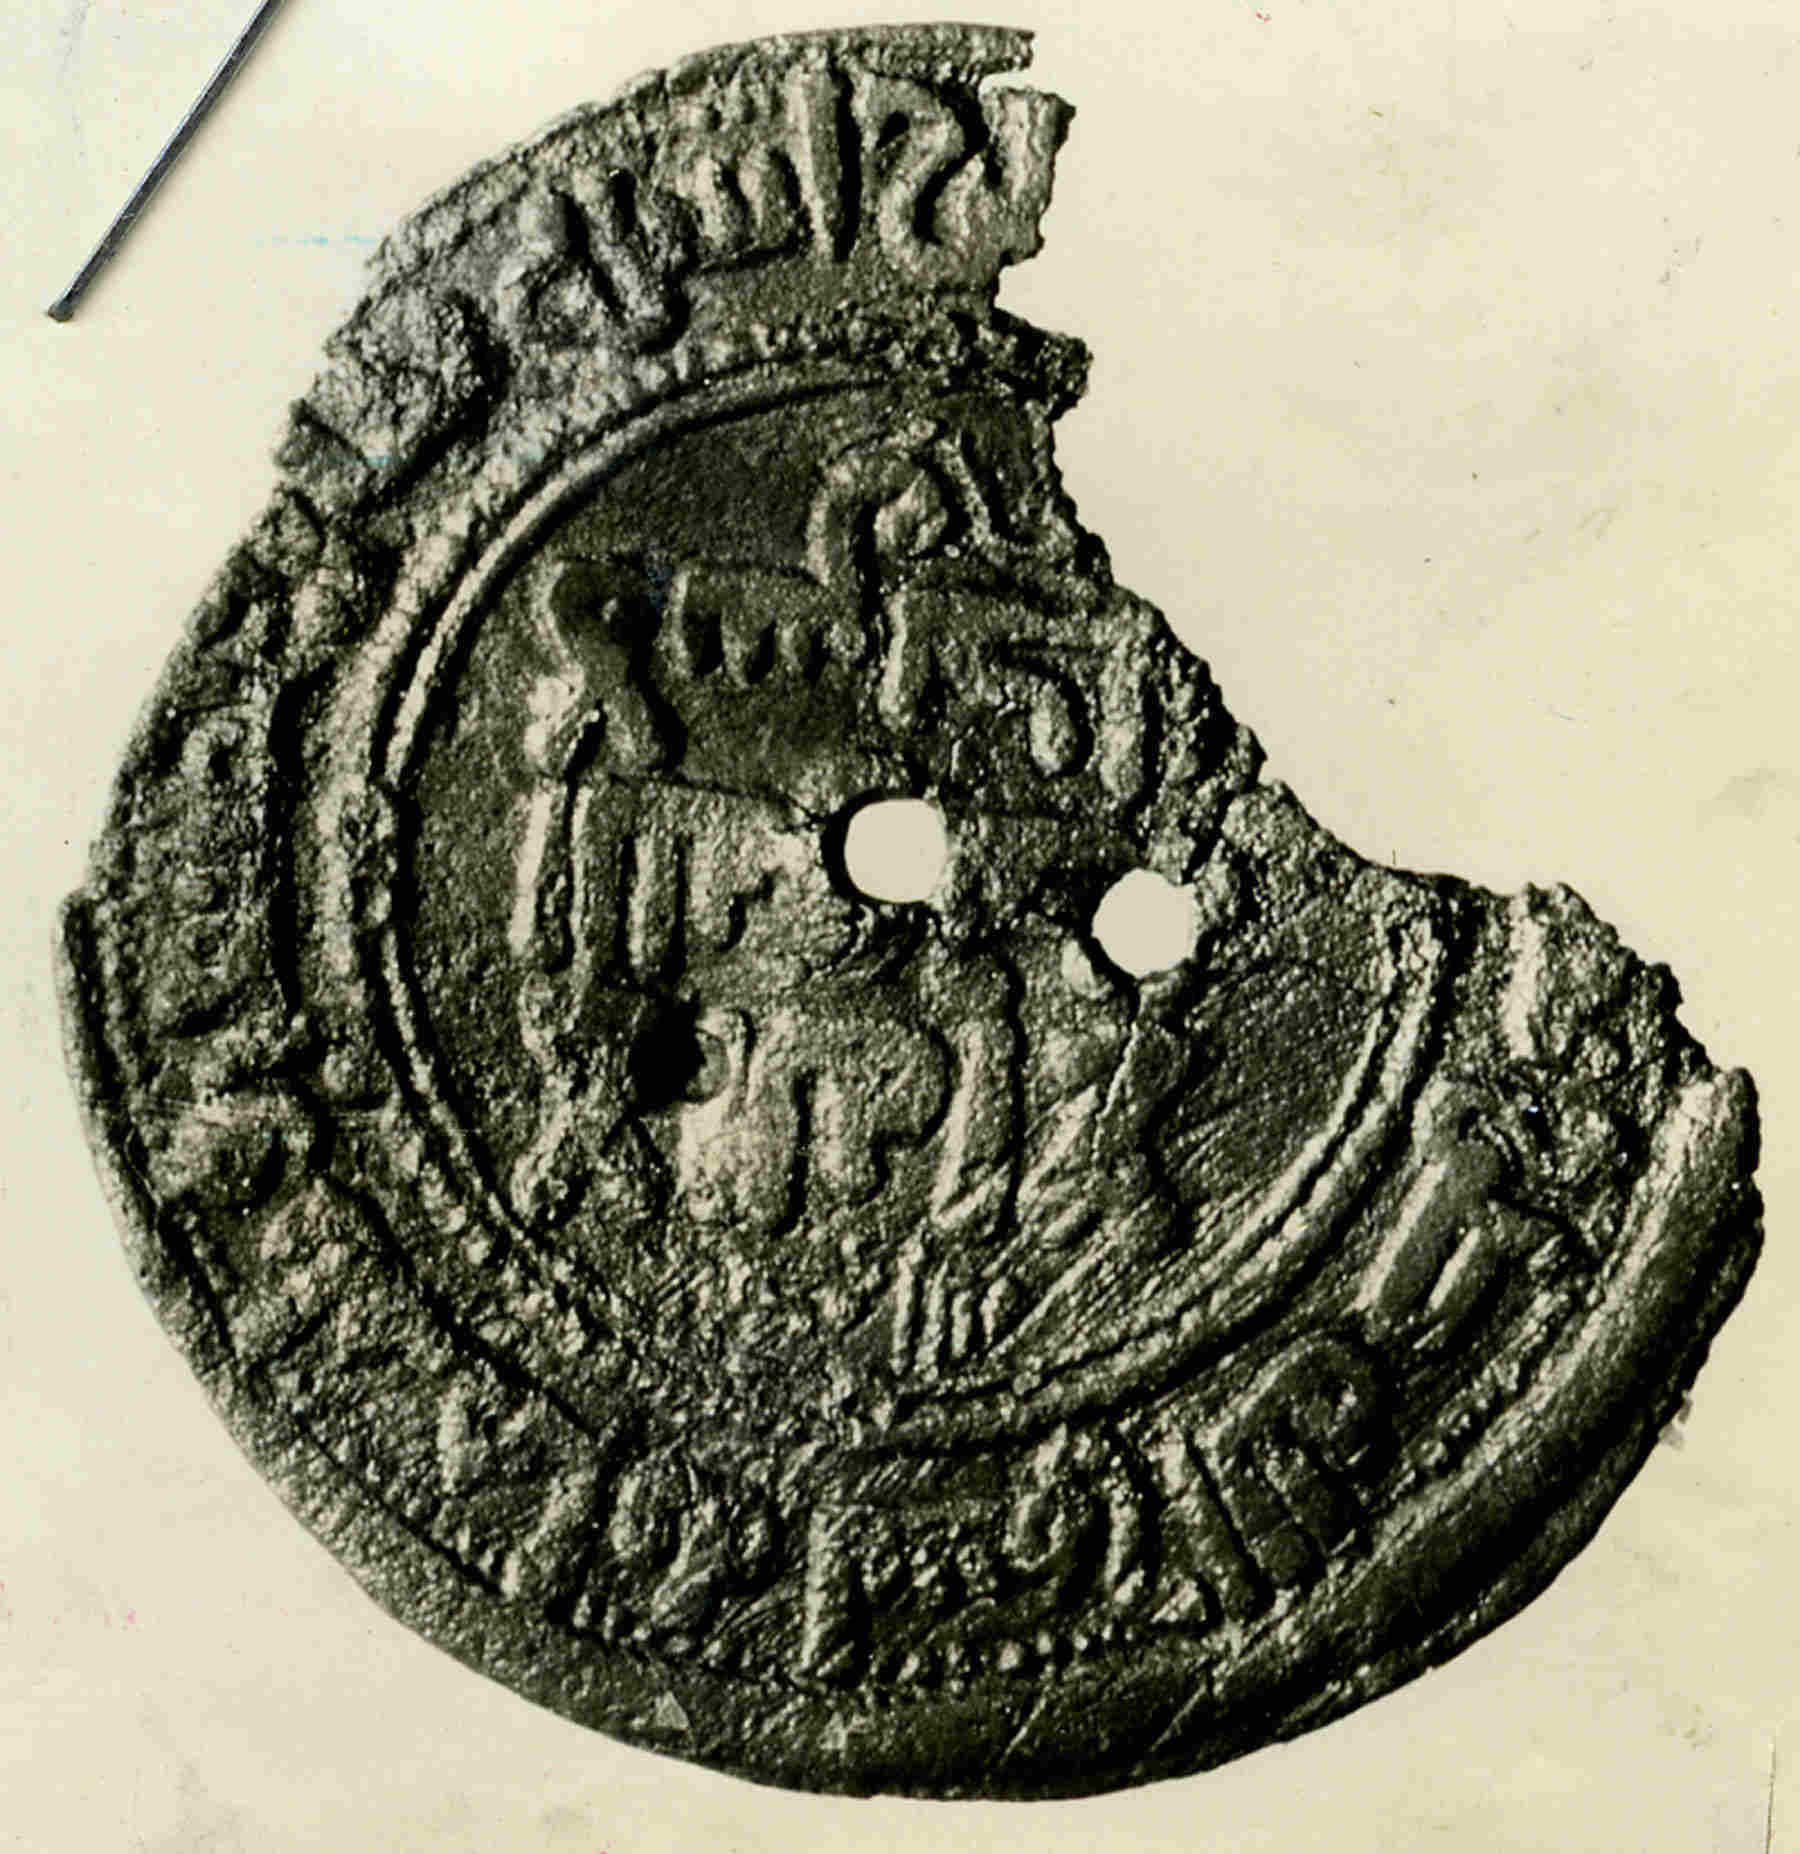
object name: coin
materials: copper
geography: uzbekistan